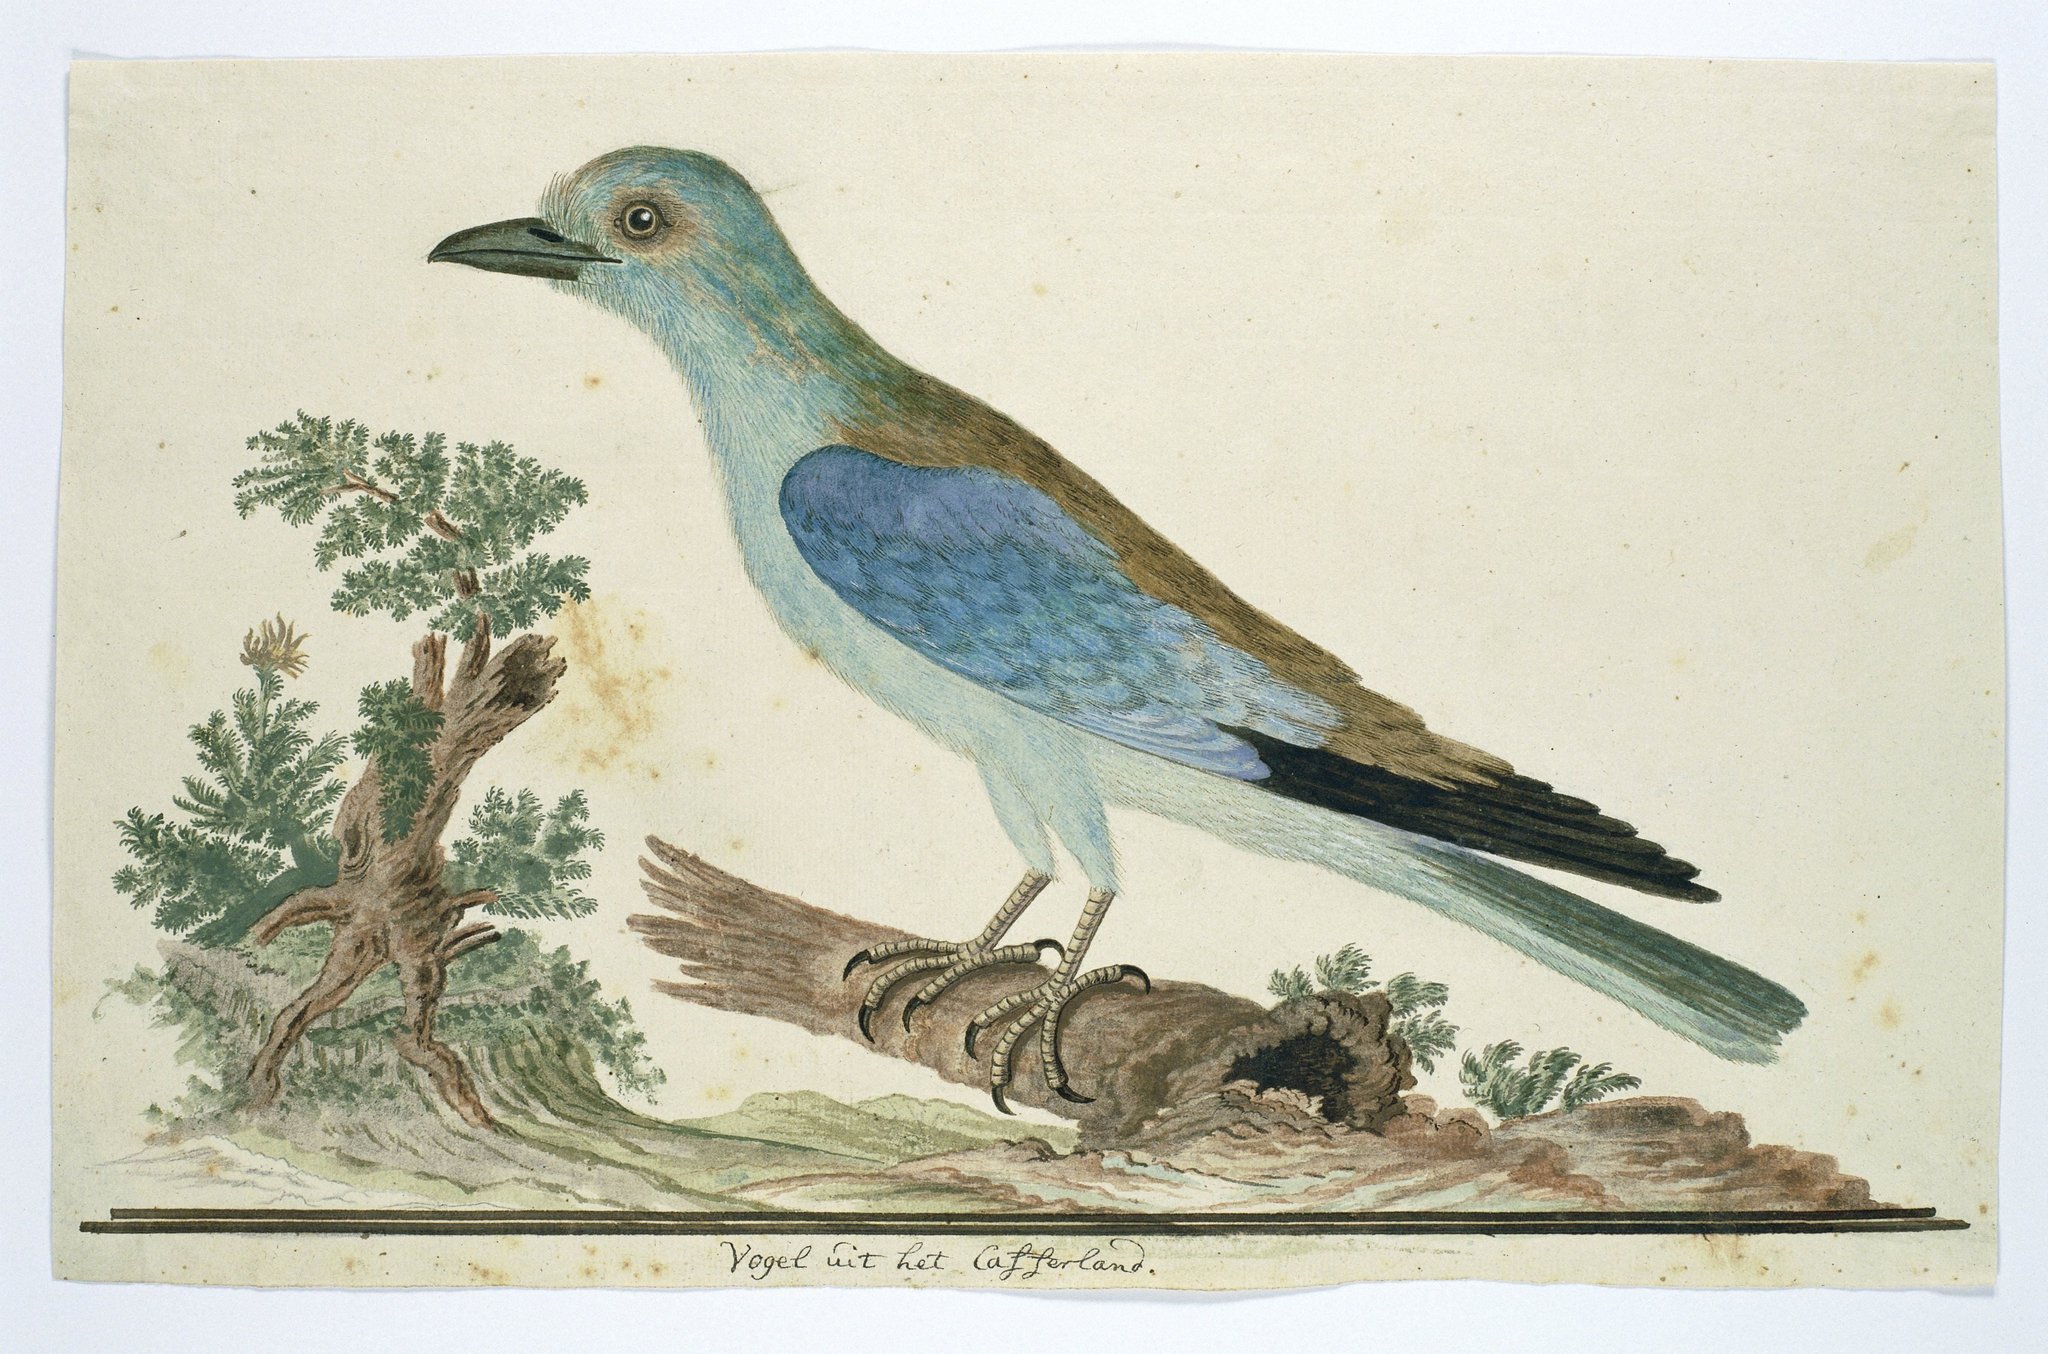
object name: album leaf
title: Coracius garrulus (European roller)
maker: robert jacob gordon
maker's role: draughtsman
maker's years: 1743-1795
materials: paint, ink, paper, pencil, watercolor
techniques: brush, pen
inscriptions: annotation: ‘Vogel uit het Cafferland.’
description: Min of meer dezelfde vogel als G. 251, maar in spiegelbeeld.